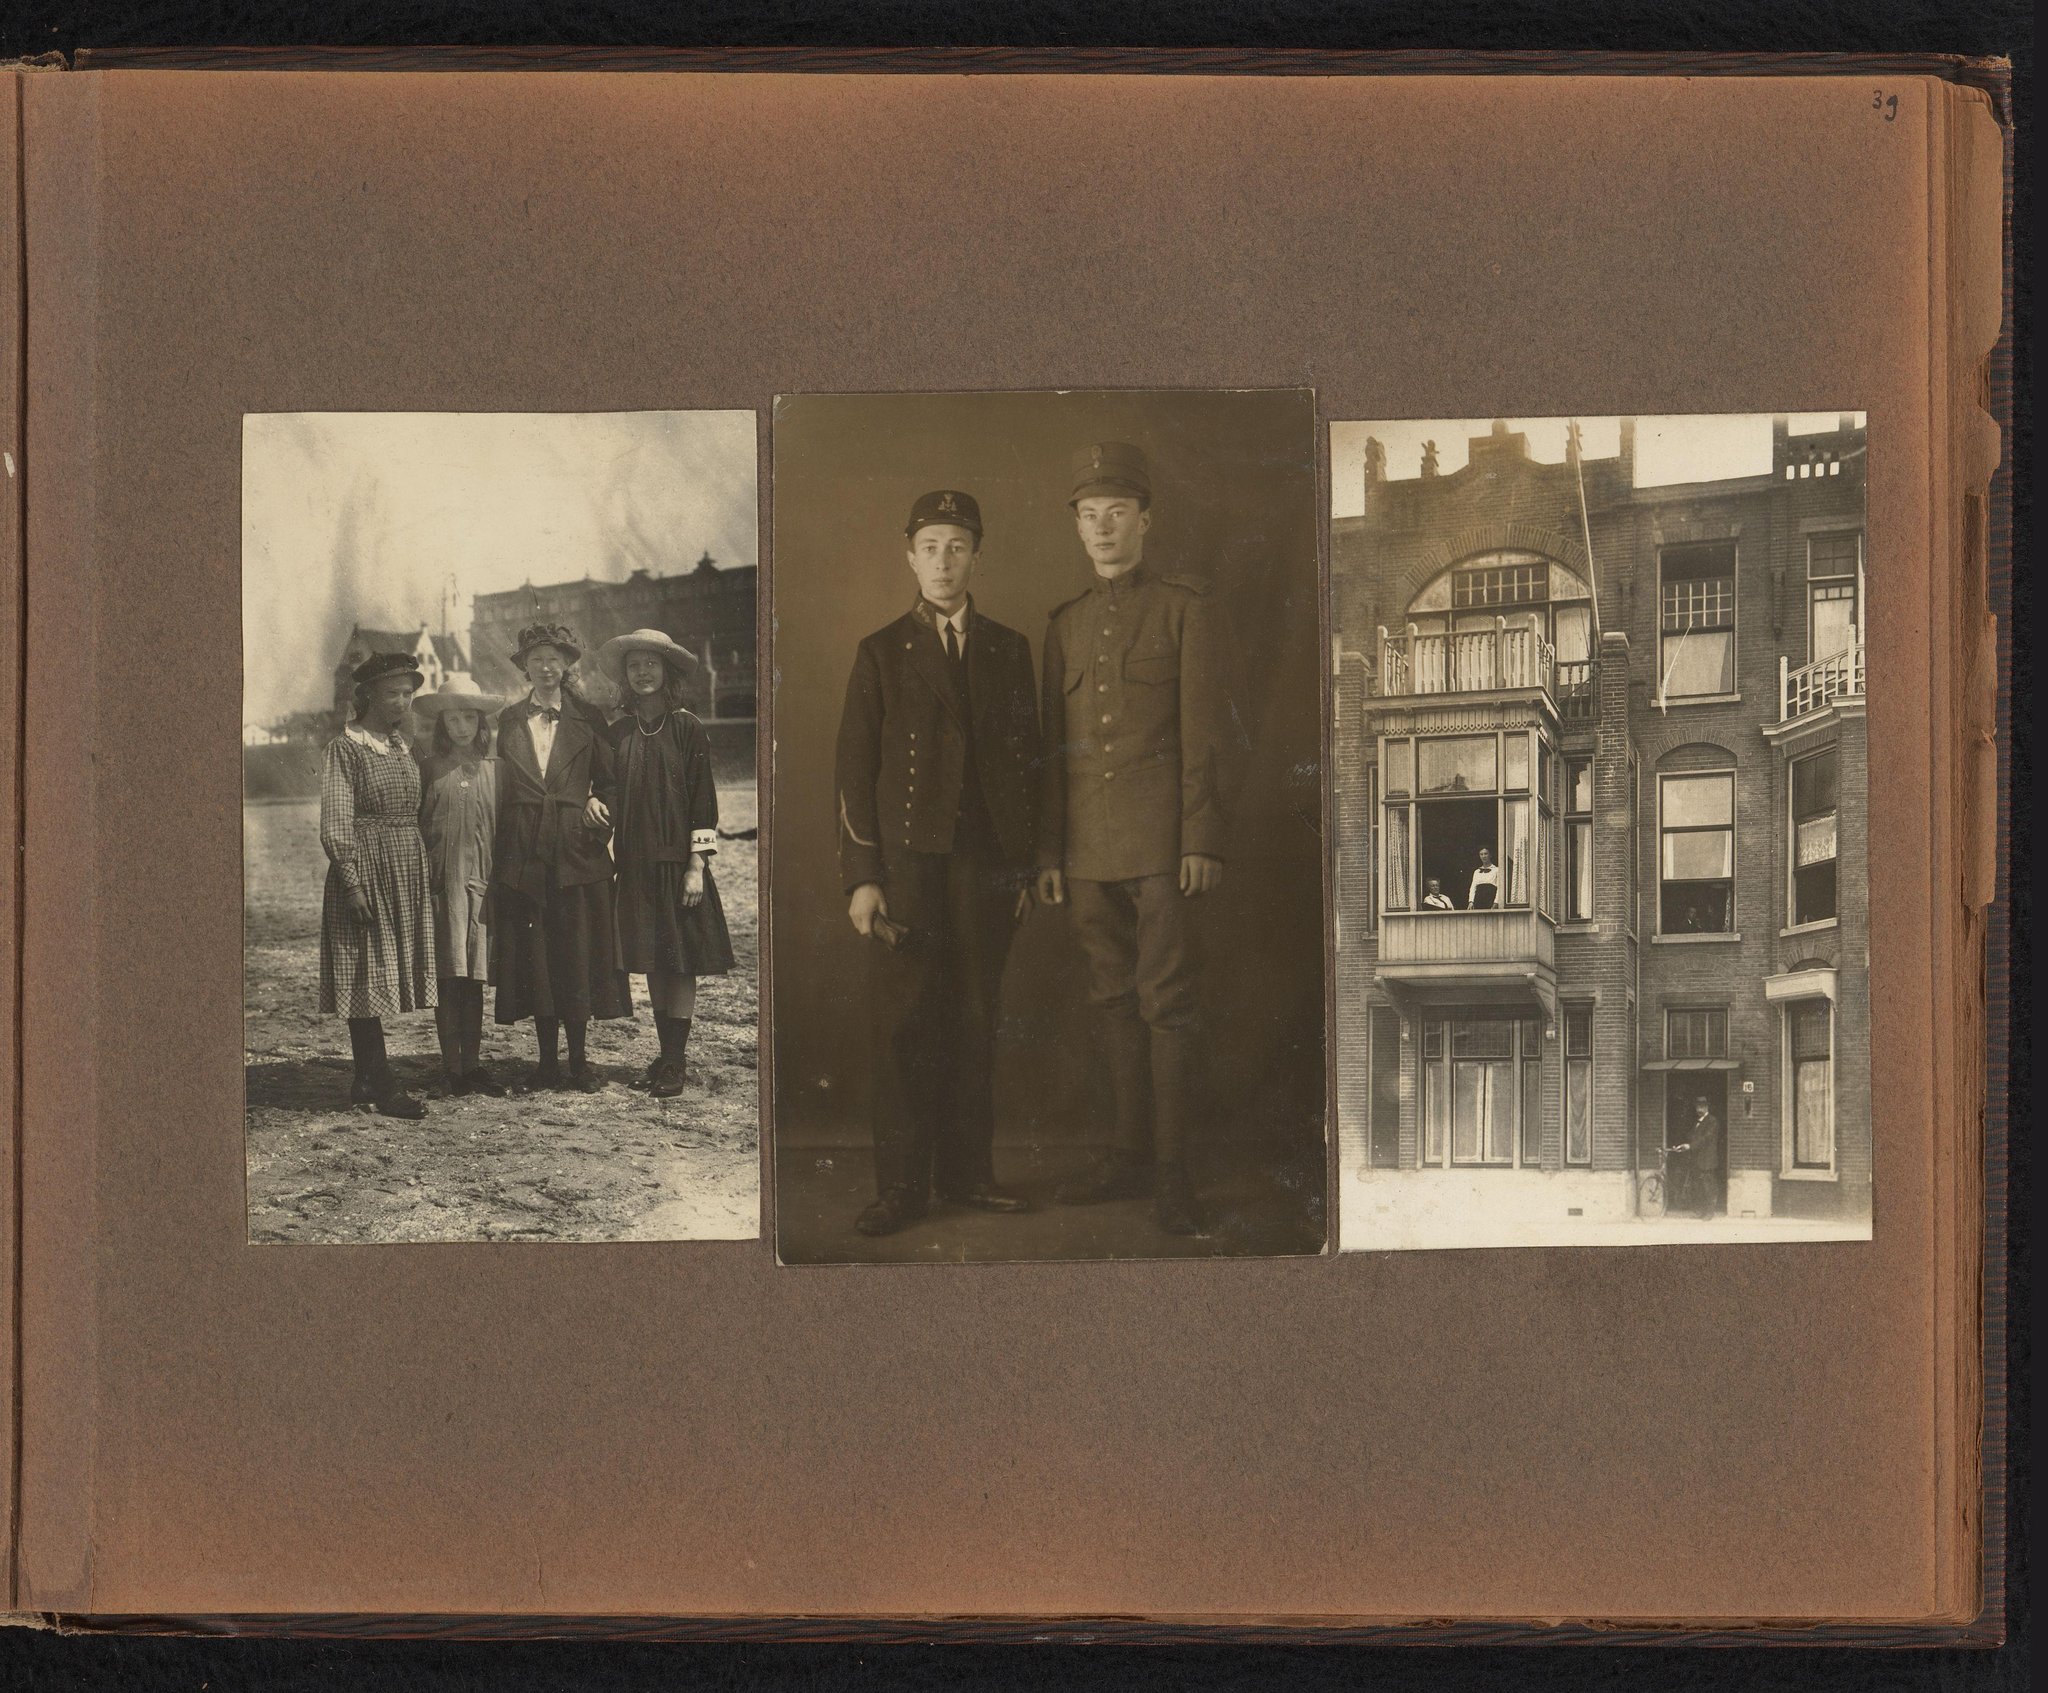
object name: album leaf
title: Bladzijde uit het fotoalbum van de familie Diepenbrock met 3 foto's van Alphons Diepenbrock en zijn omgeving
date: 1870-1920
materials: cardboard, photographic support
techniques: photography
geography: netherlands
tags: netherlands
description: Bruin albumblad 39 van familiealbum van Alphons Diepenbrock.